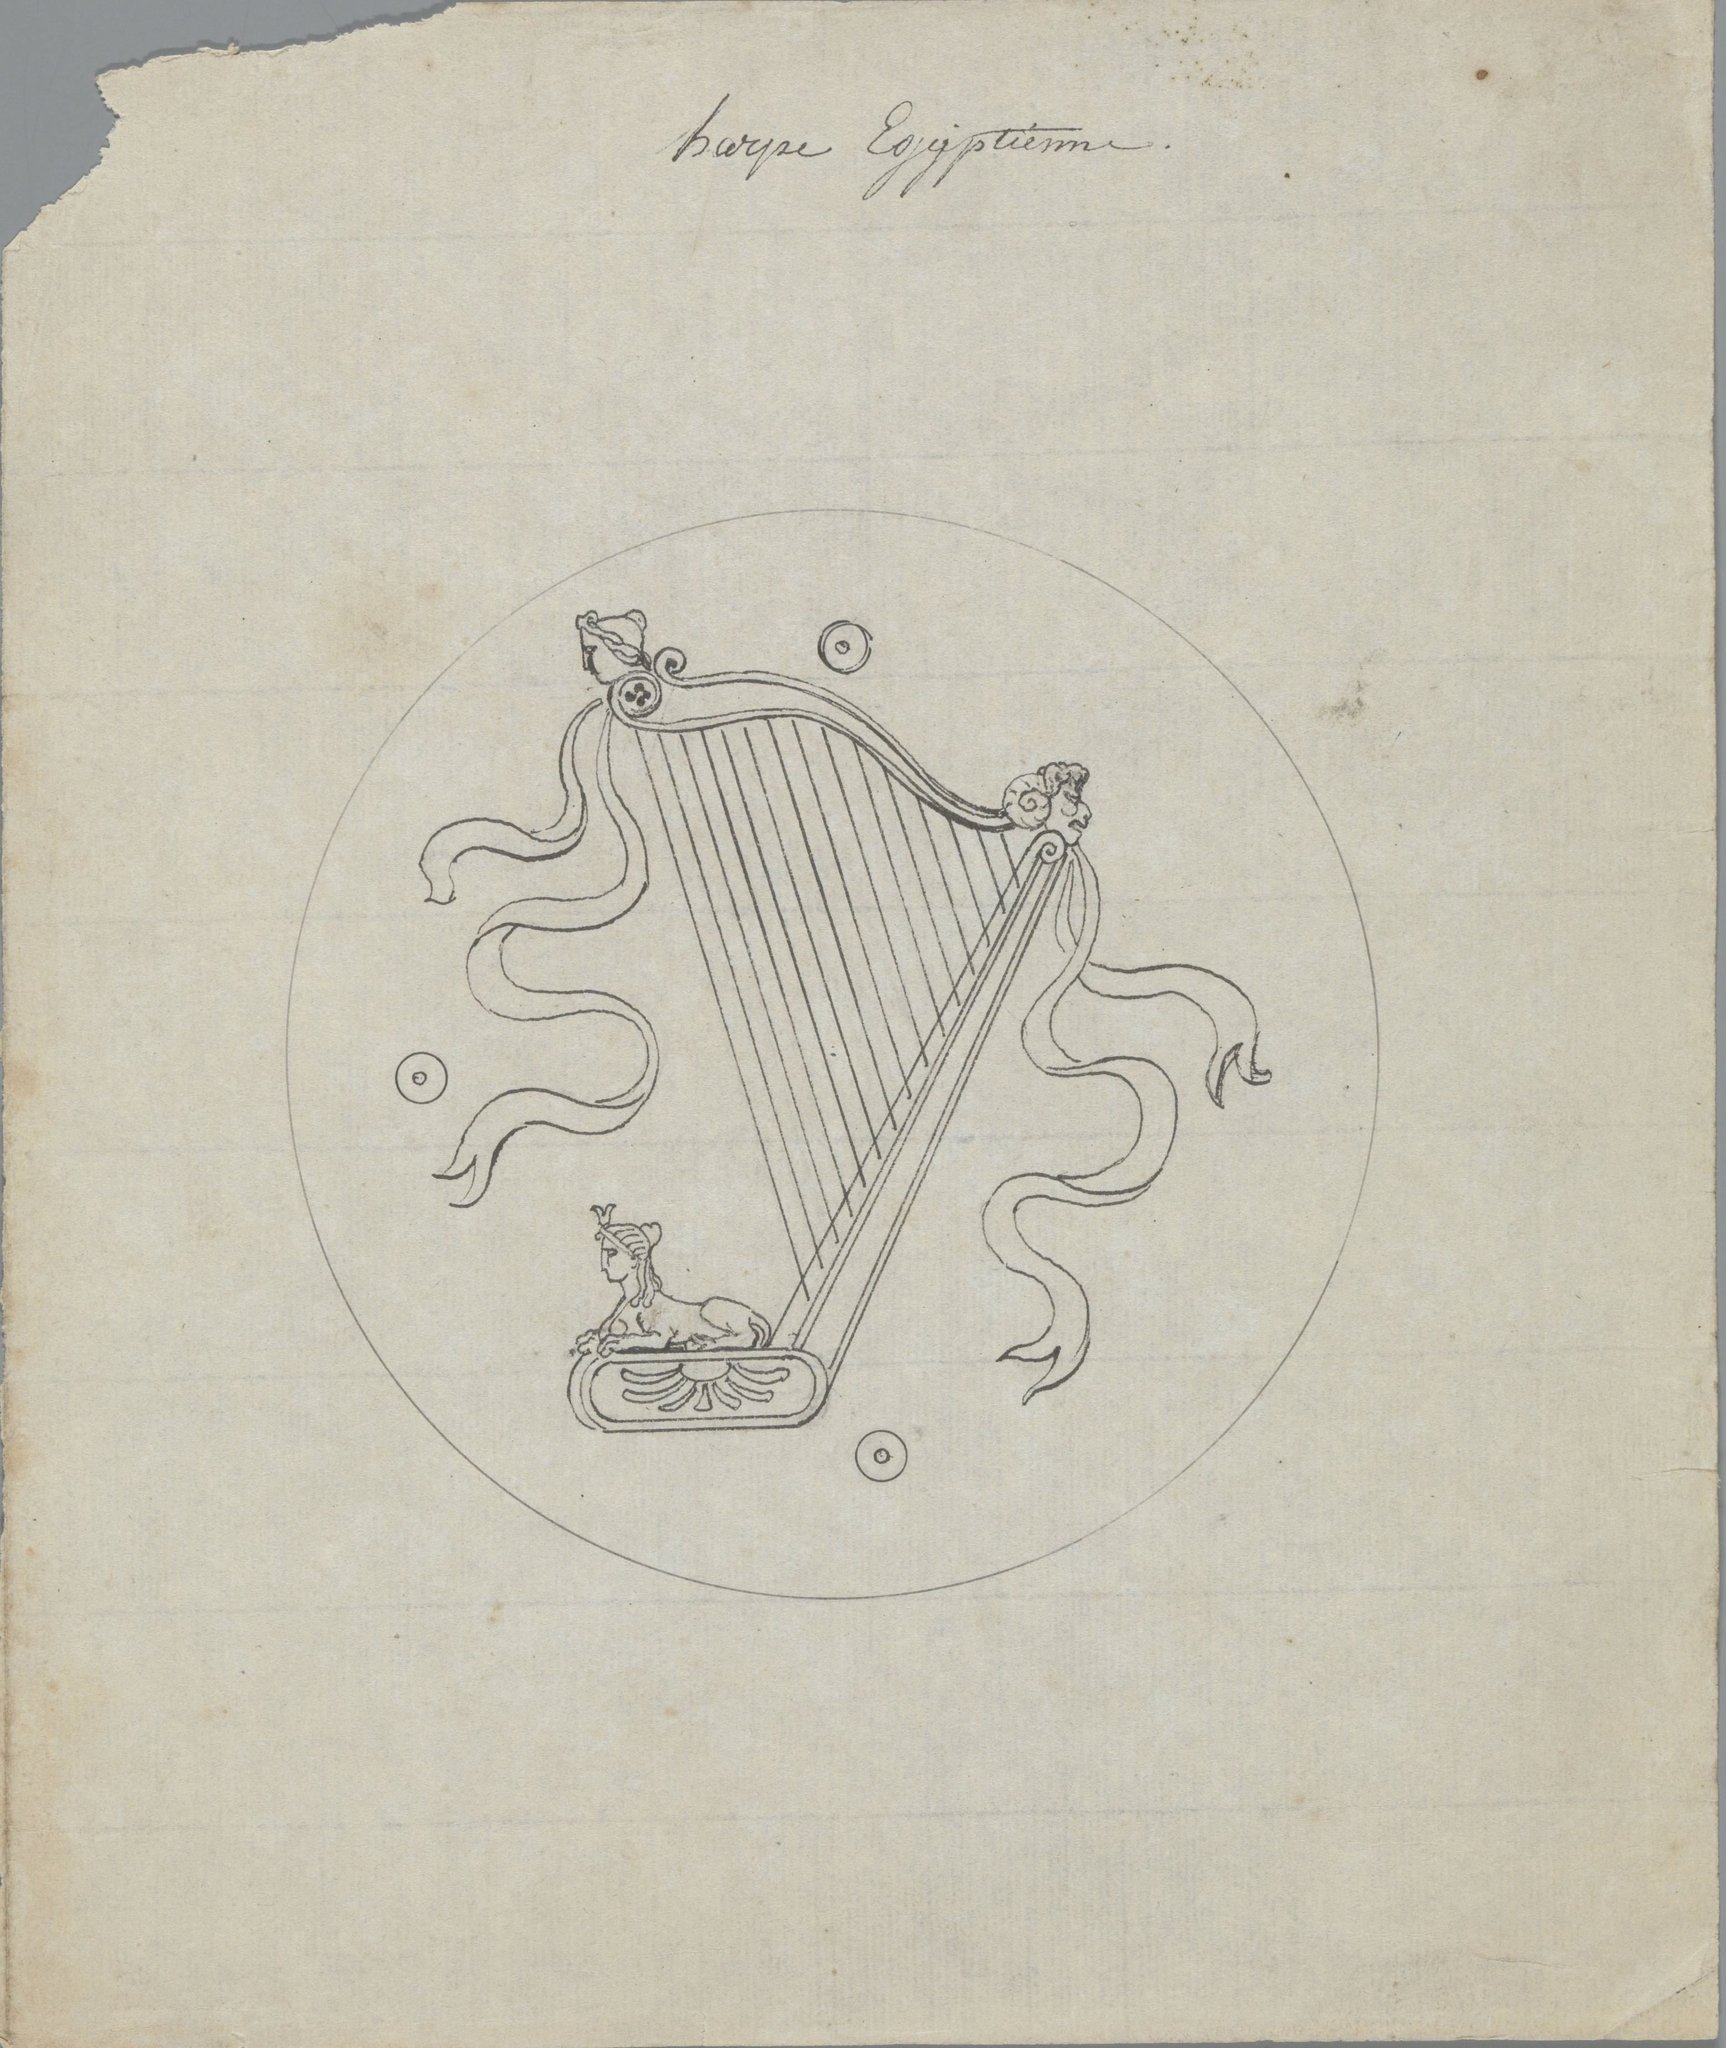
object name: design drawing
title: Ontwerp voor marqueterie van aan linten opgehangen muziekinstrument(en) in rond medaillon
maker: pierre félix van doren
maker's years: 1797-1856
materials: graphite, ink, paper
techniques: pen in black ink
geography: brussels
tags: trophy, i.e.: decorative arrangement of symbolic or typical objects ~ ornament, harp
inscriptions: inscription: ‘harpe Egyptienne’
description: Een van 103 ontwerpen voor marqueterie van aan linten opgehangen muziekinstrumenten in ronde medaillons, bestemd voor de set stoelen gemaakt door Van Doren voor de grote zaal van het Paleis van de Prins van Oranje in Brussel in 1828.